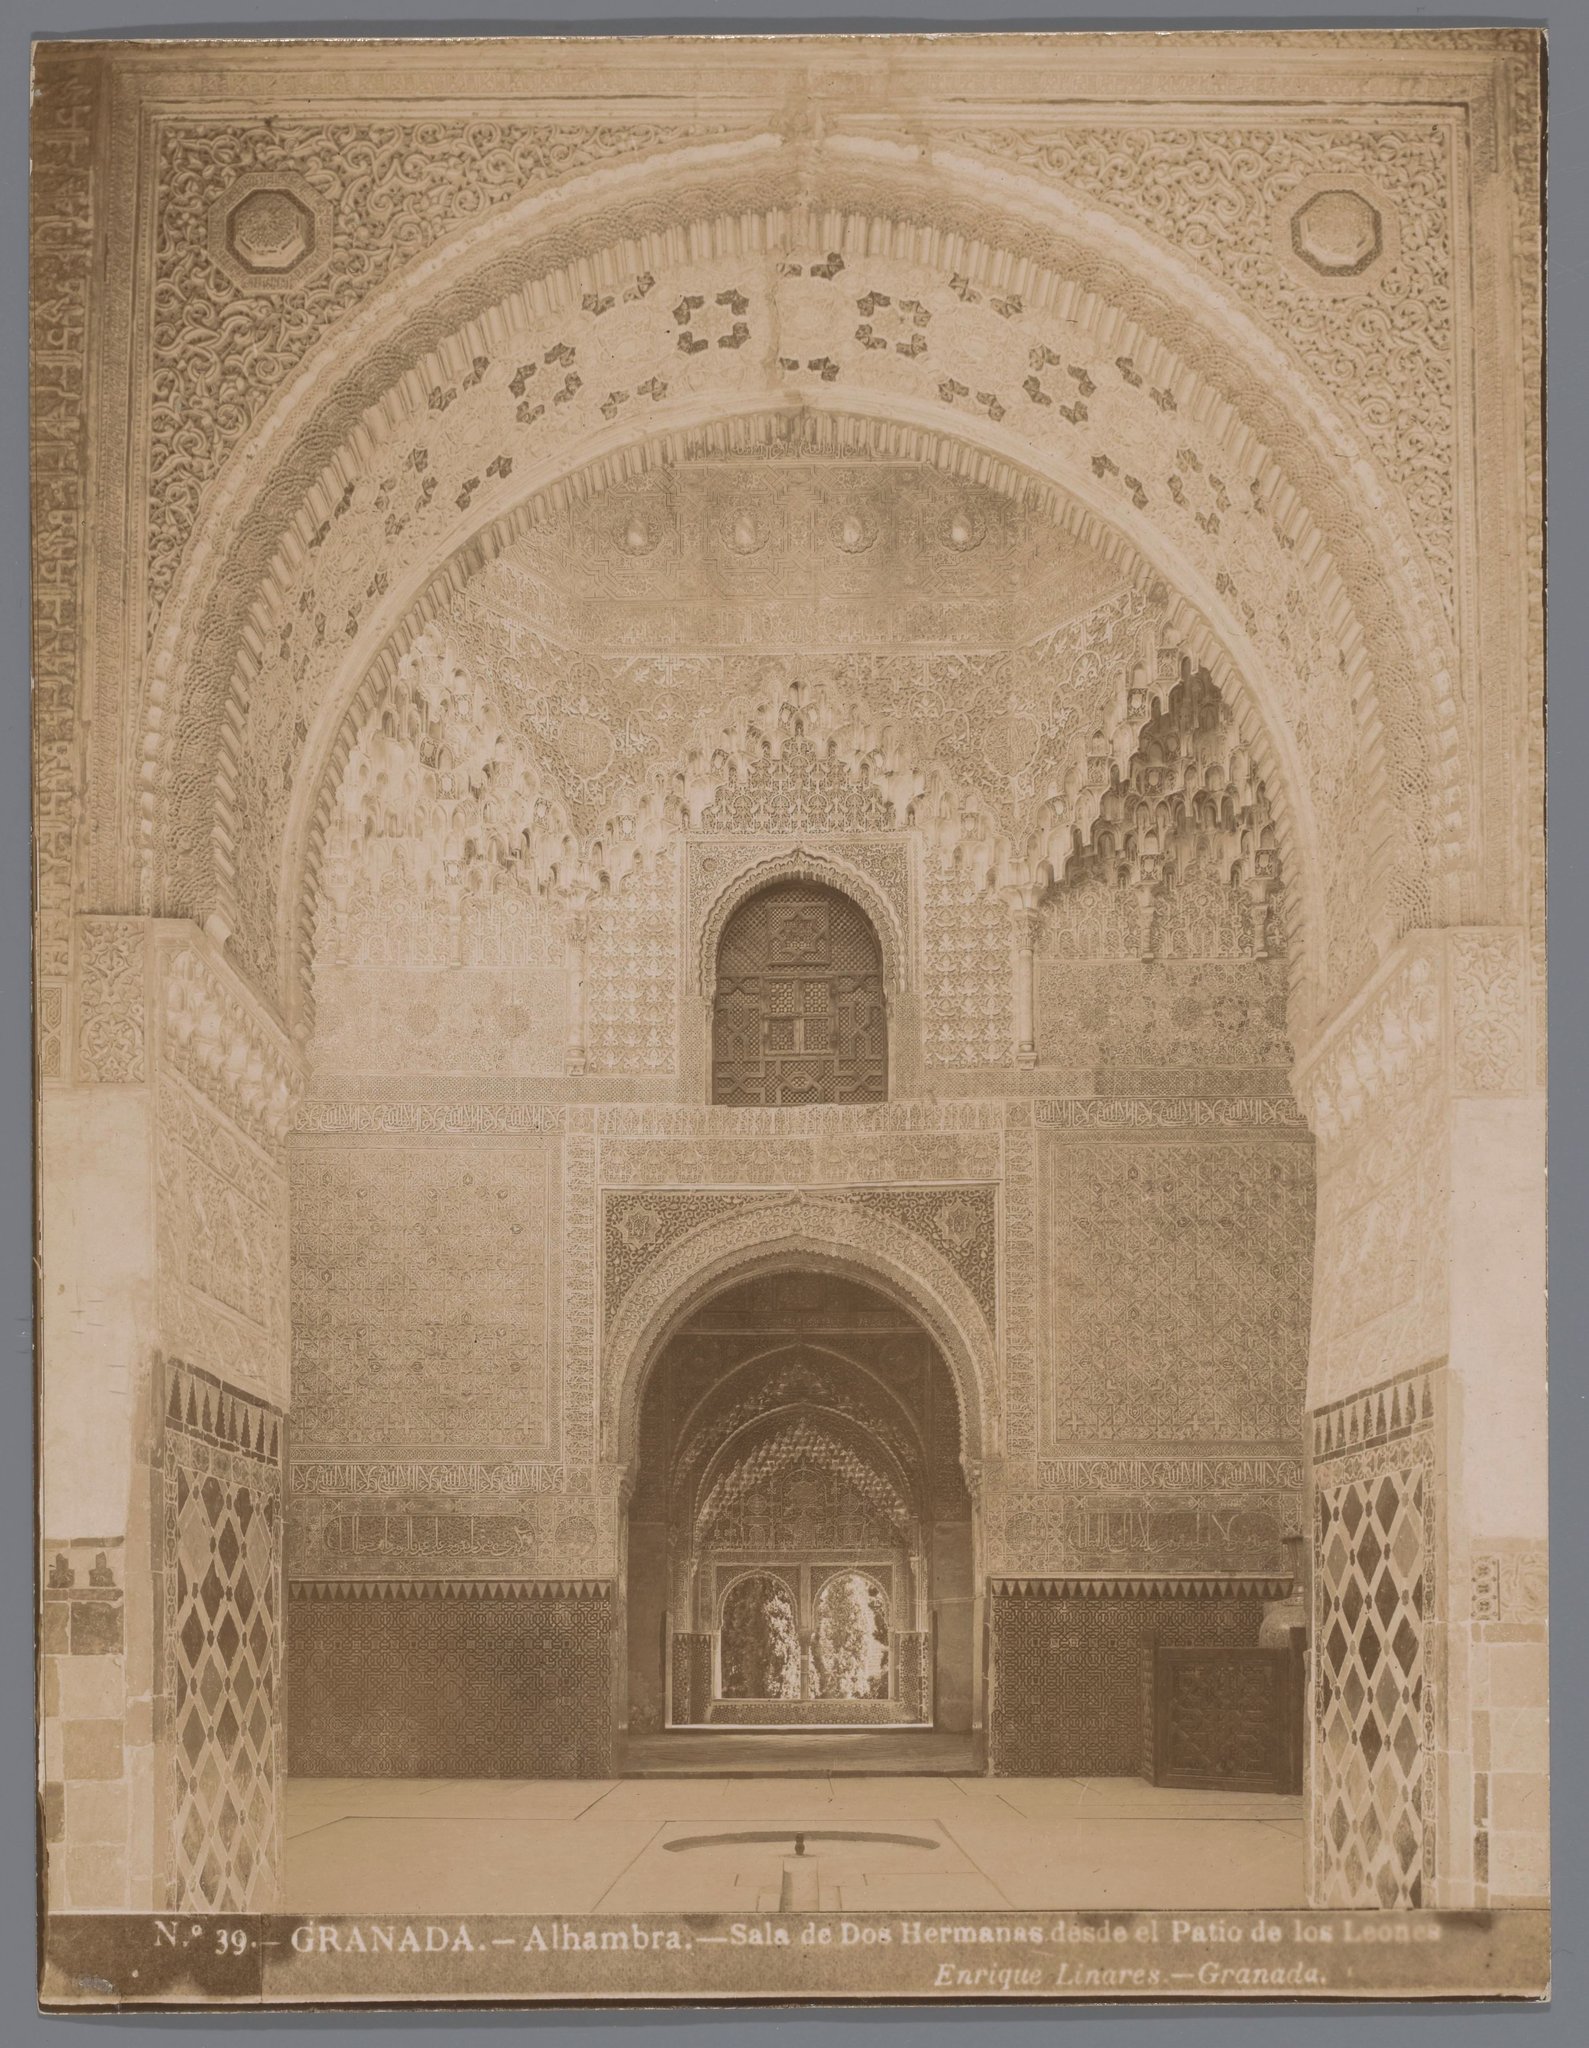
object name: photograph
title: Granada, Alhambra, Sala de Dos Hermanas desde el Patio de los Leones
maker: enrique linares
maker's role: fotograaf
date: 1900-1930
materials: paper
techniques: gelatin silver print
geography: granada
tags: palace - aa - civic architecture: inside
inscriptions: number: ‘No 39.’